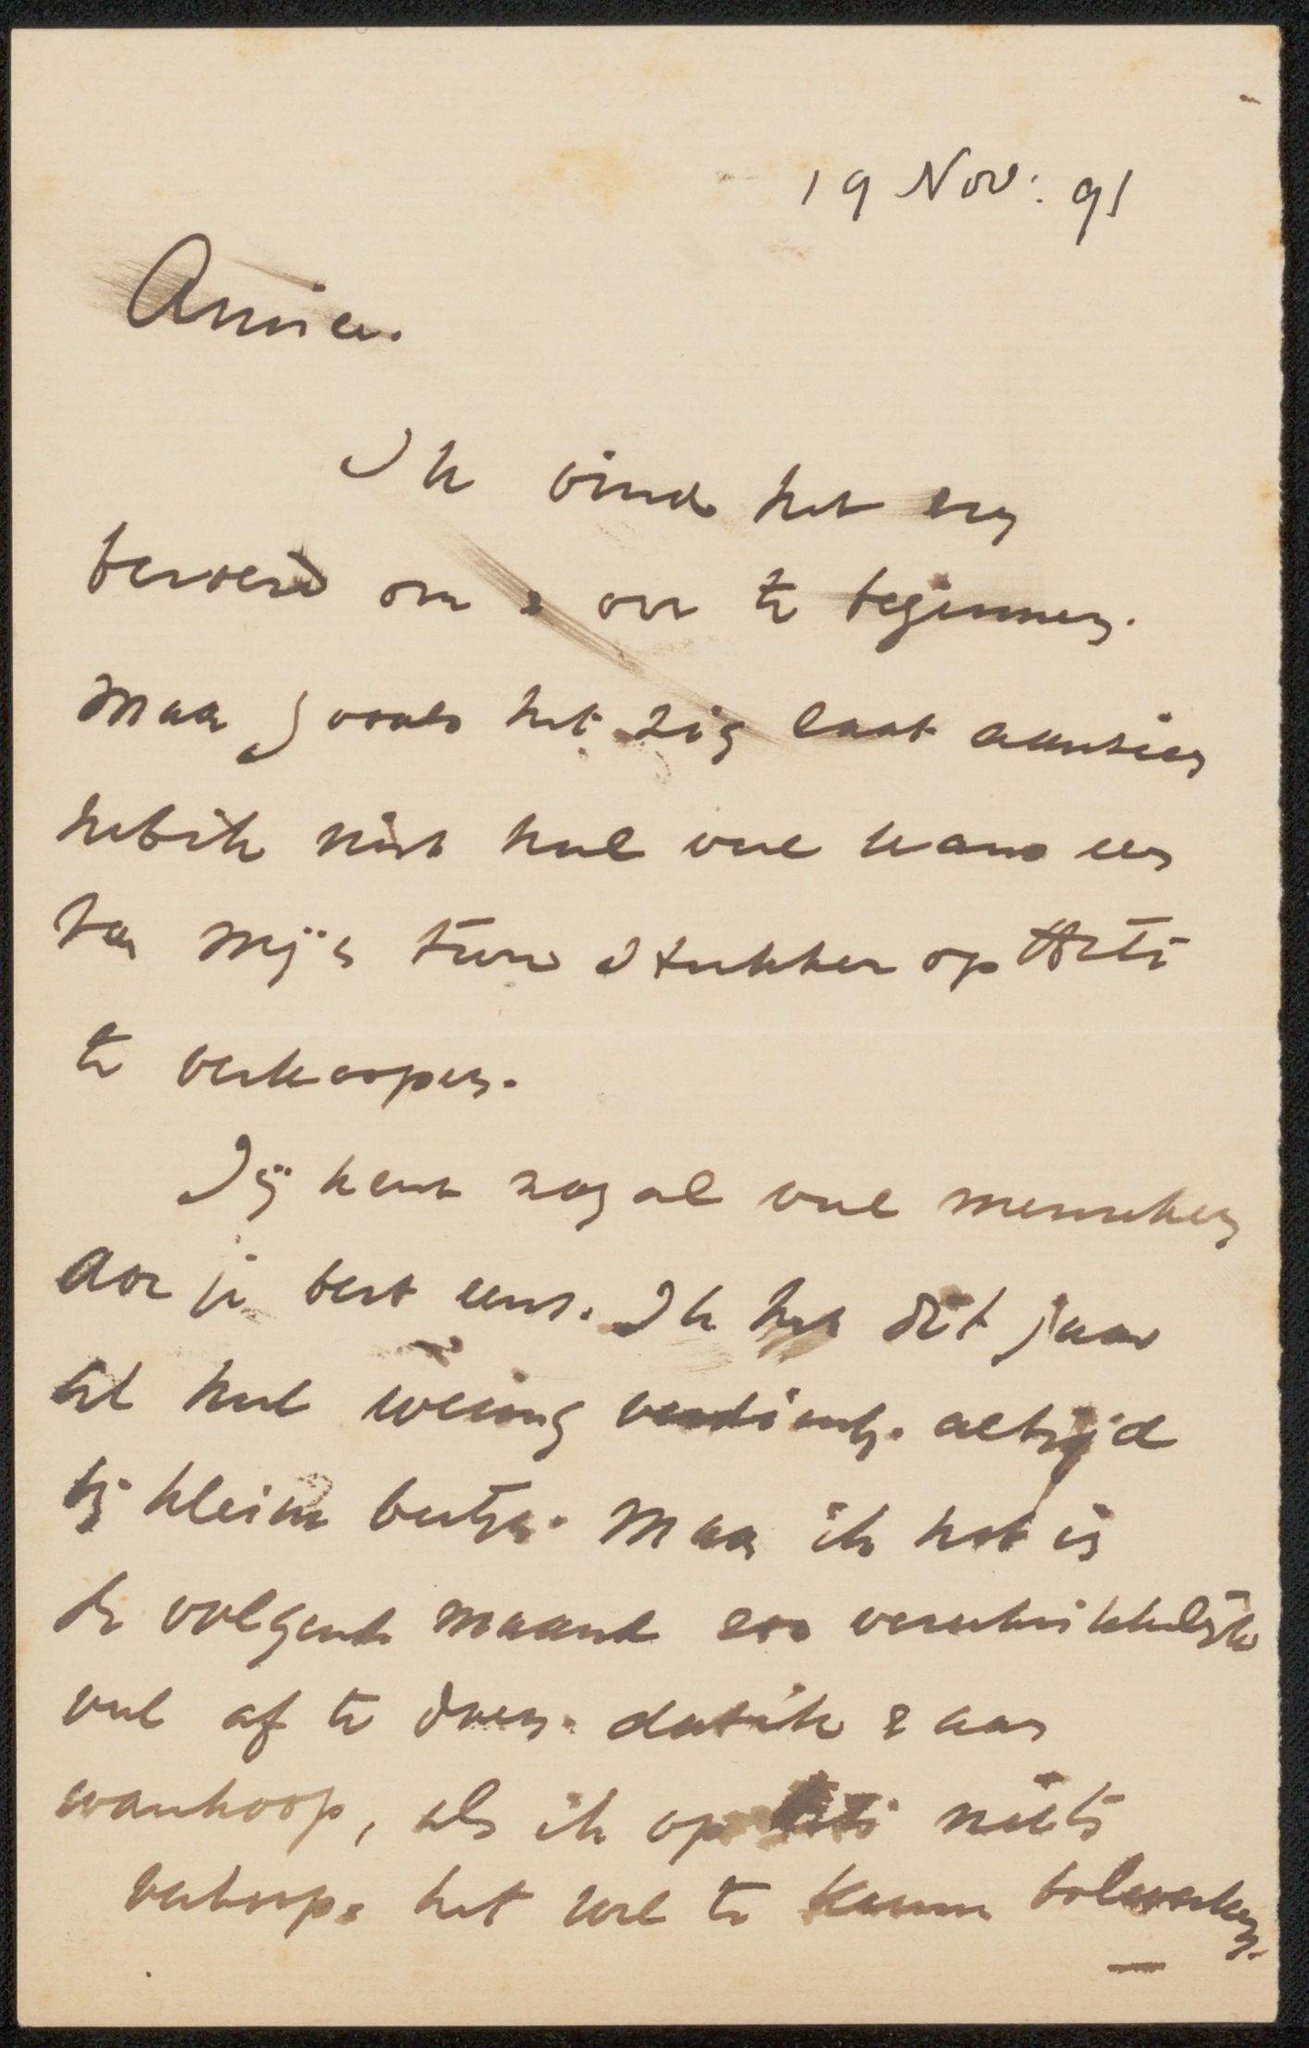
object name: letter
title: Brief aan Jan Veth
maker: george hendrik breitner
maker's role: draughtsman, painter, print maker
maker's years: 1857-1923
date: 1891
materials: ink, paper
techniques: pen, writing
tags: dordrecht, designer, jan veth, art trade, art shop, money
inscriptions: collector's mark: ‘RPK’, watermark